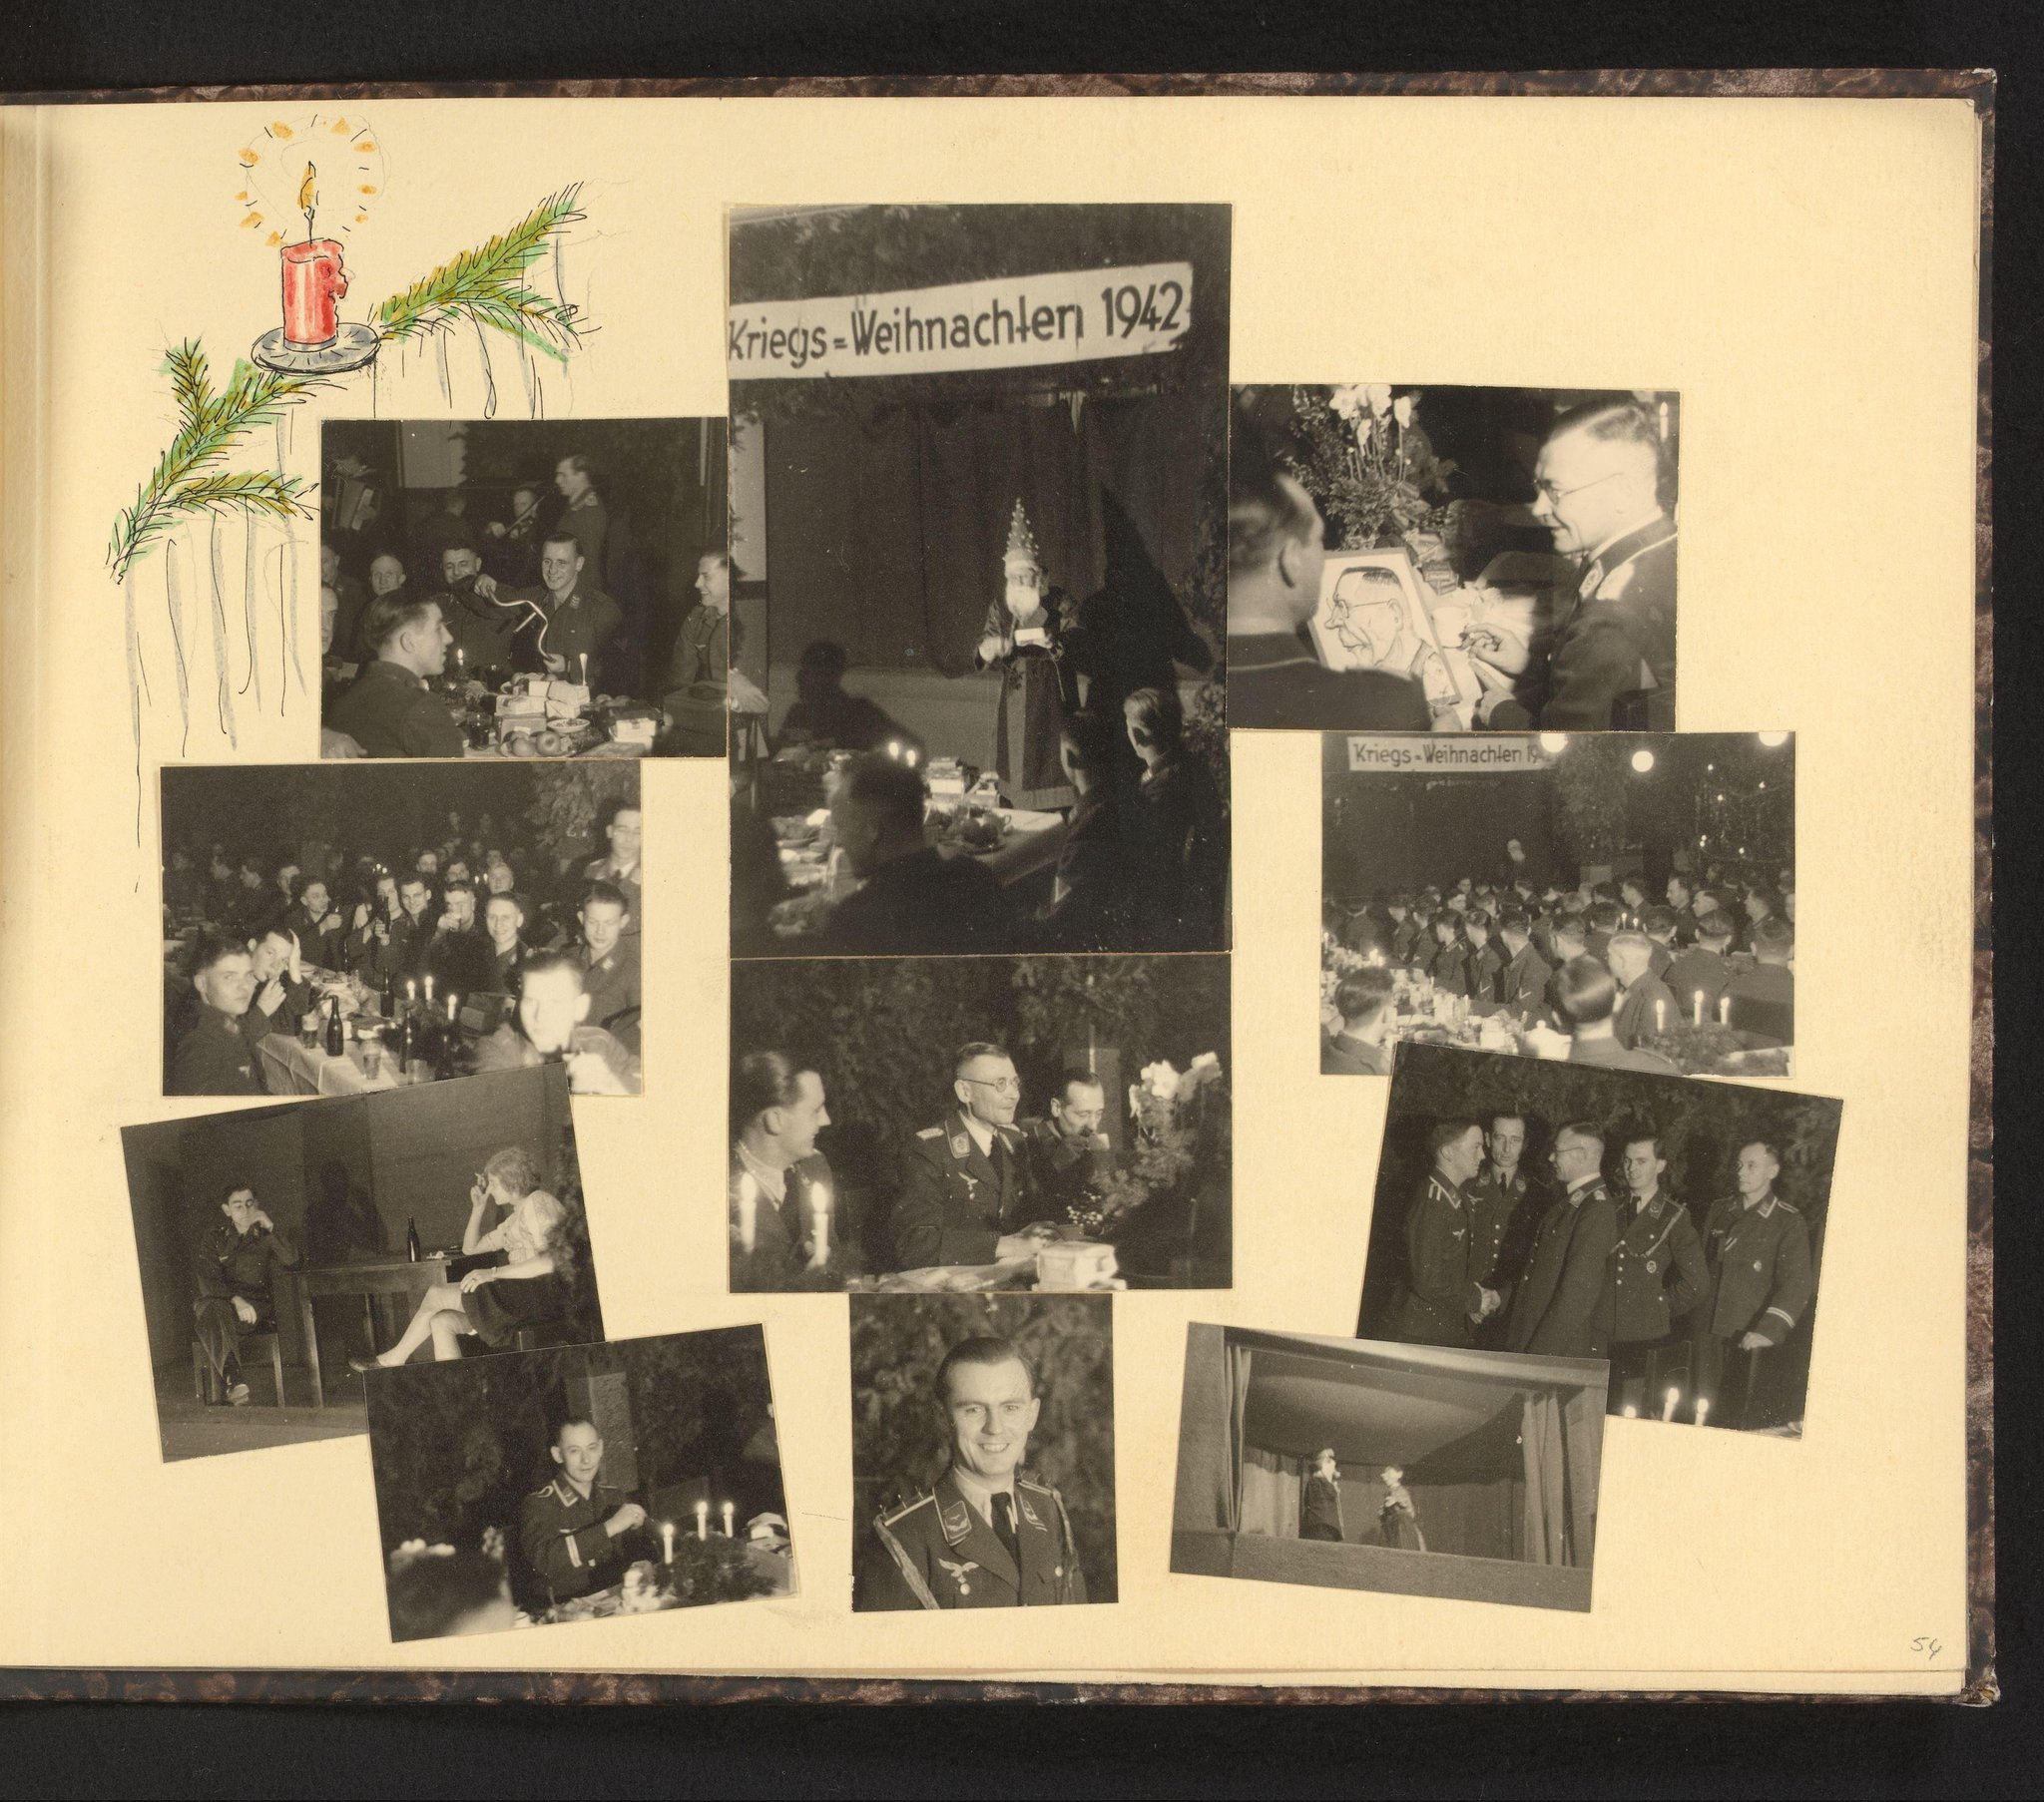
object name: album leaf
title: Kerst 1942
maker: Anonymous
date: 1912-1942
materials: cardboard, photographic support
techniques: drawing, gelatin silver print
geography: breda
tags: the company, the unit, the troop ~ military service, christmas (non-liturgical celebration), man dressed as woman, travesty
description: Albumblad met een collage van elf foto's en een tekening van de kerstviering in 1942 (Kriegs-Weihnachten 1942). Foto´s van de gezamenlijke kerstmaaltijd, kerstman, toespraken, portretten, toneelstuk met travestie en poppenkast. ONderdeel van het fotoalbum van de Luftnachrichten-Regiment 211,1942-1943.